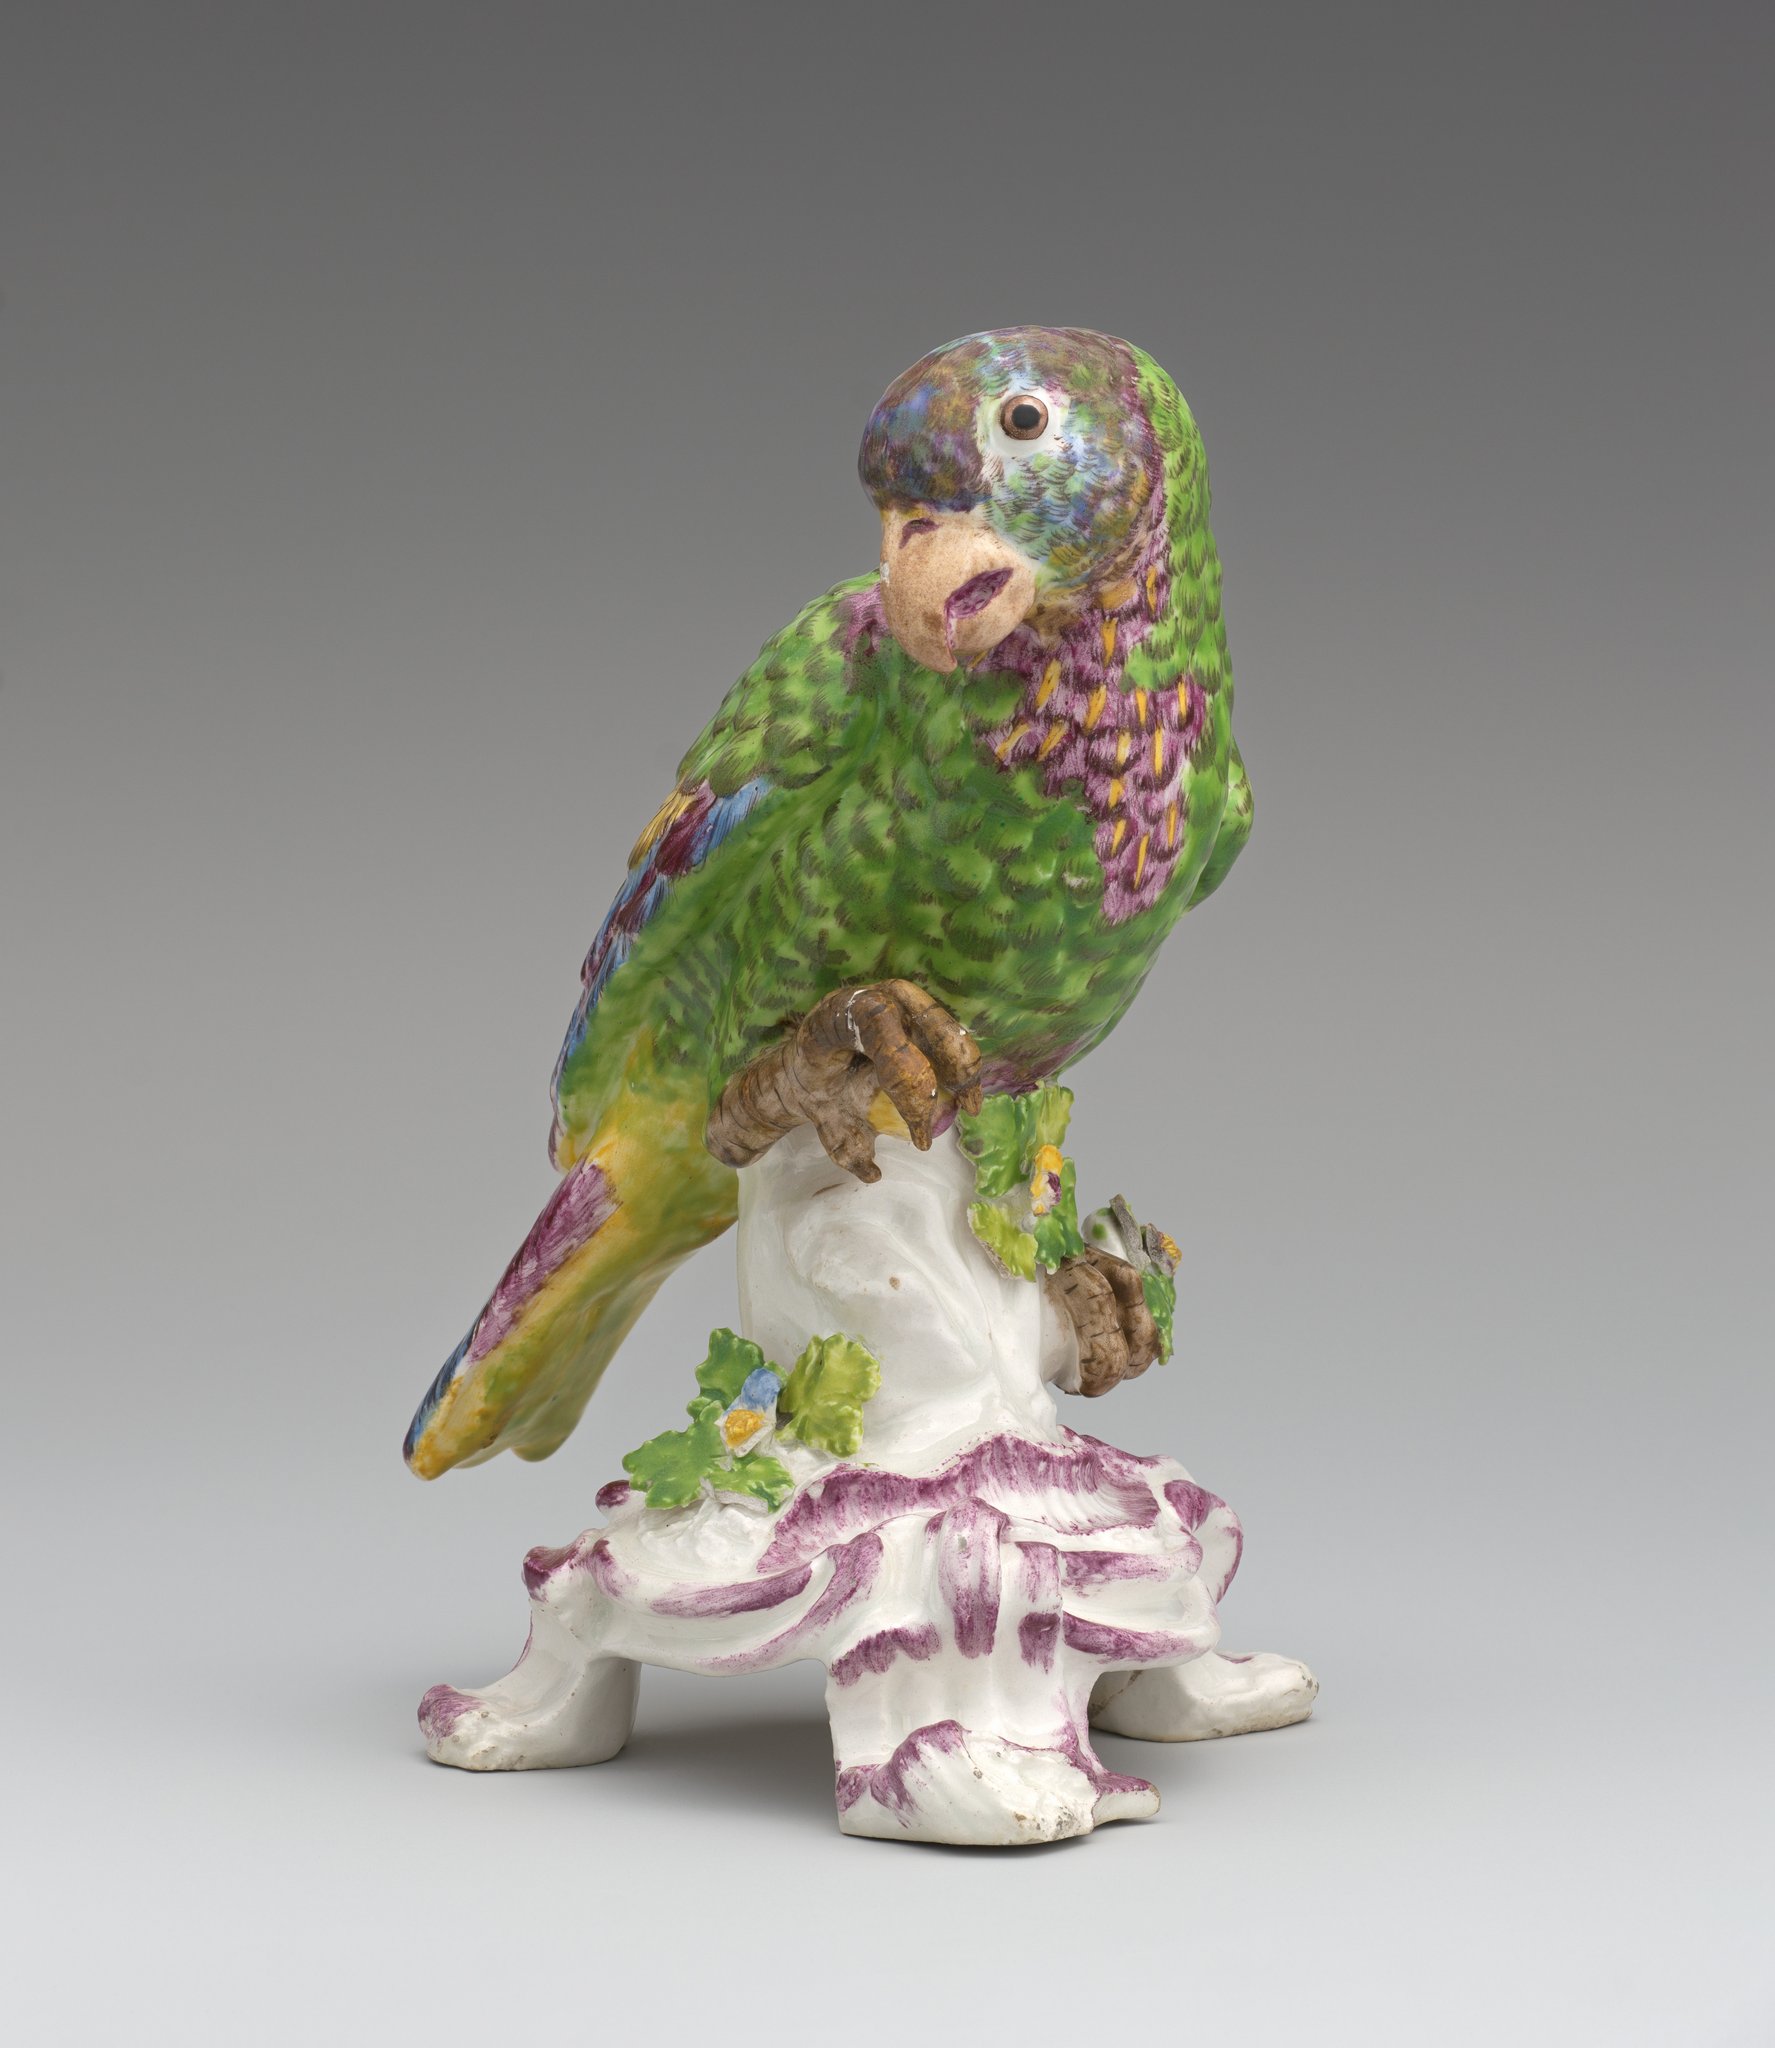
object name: figure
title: Parrot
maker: bow porcelain factory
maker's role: factory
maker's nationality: british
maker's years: 1747-1776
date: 1760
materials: soft paste porcelain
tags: parrots